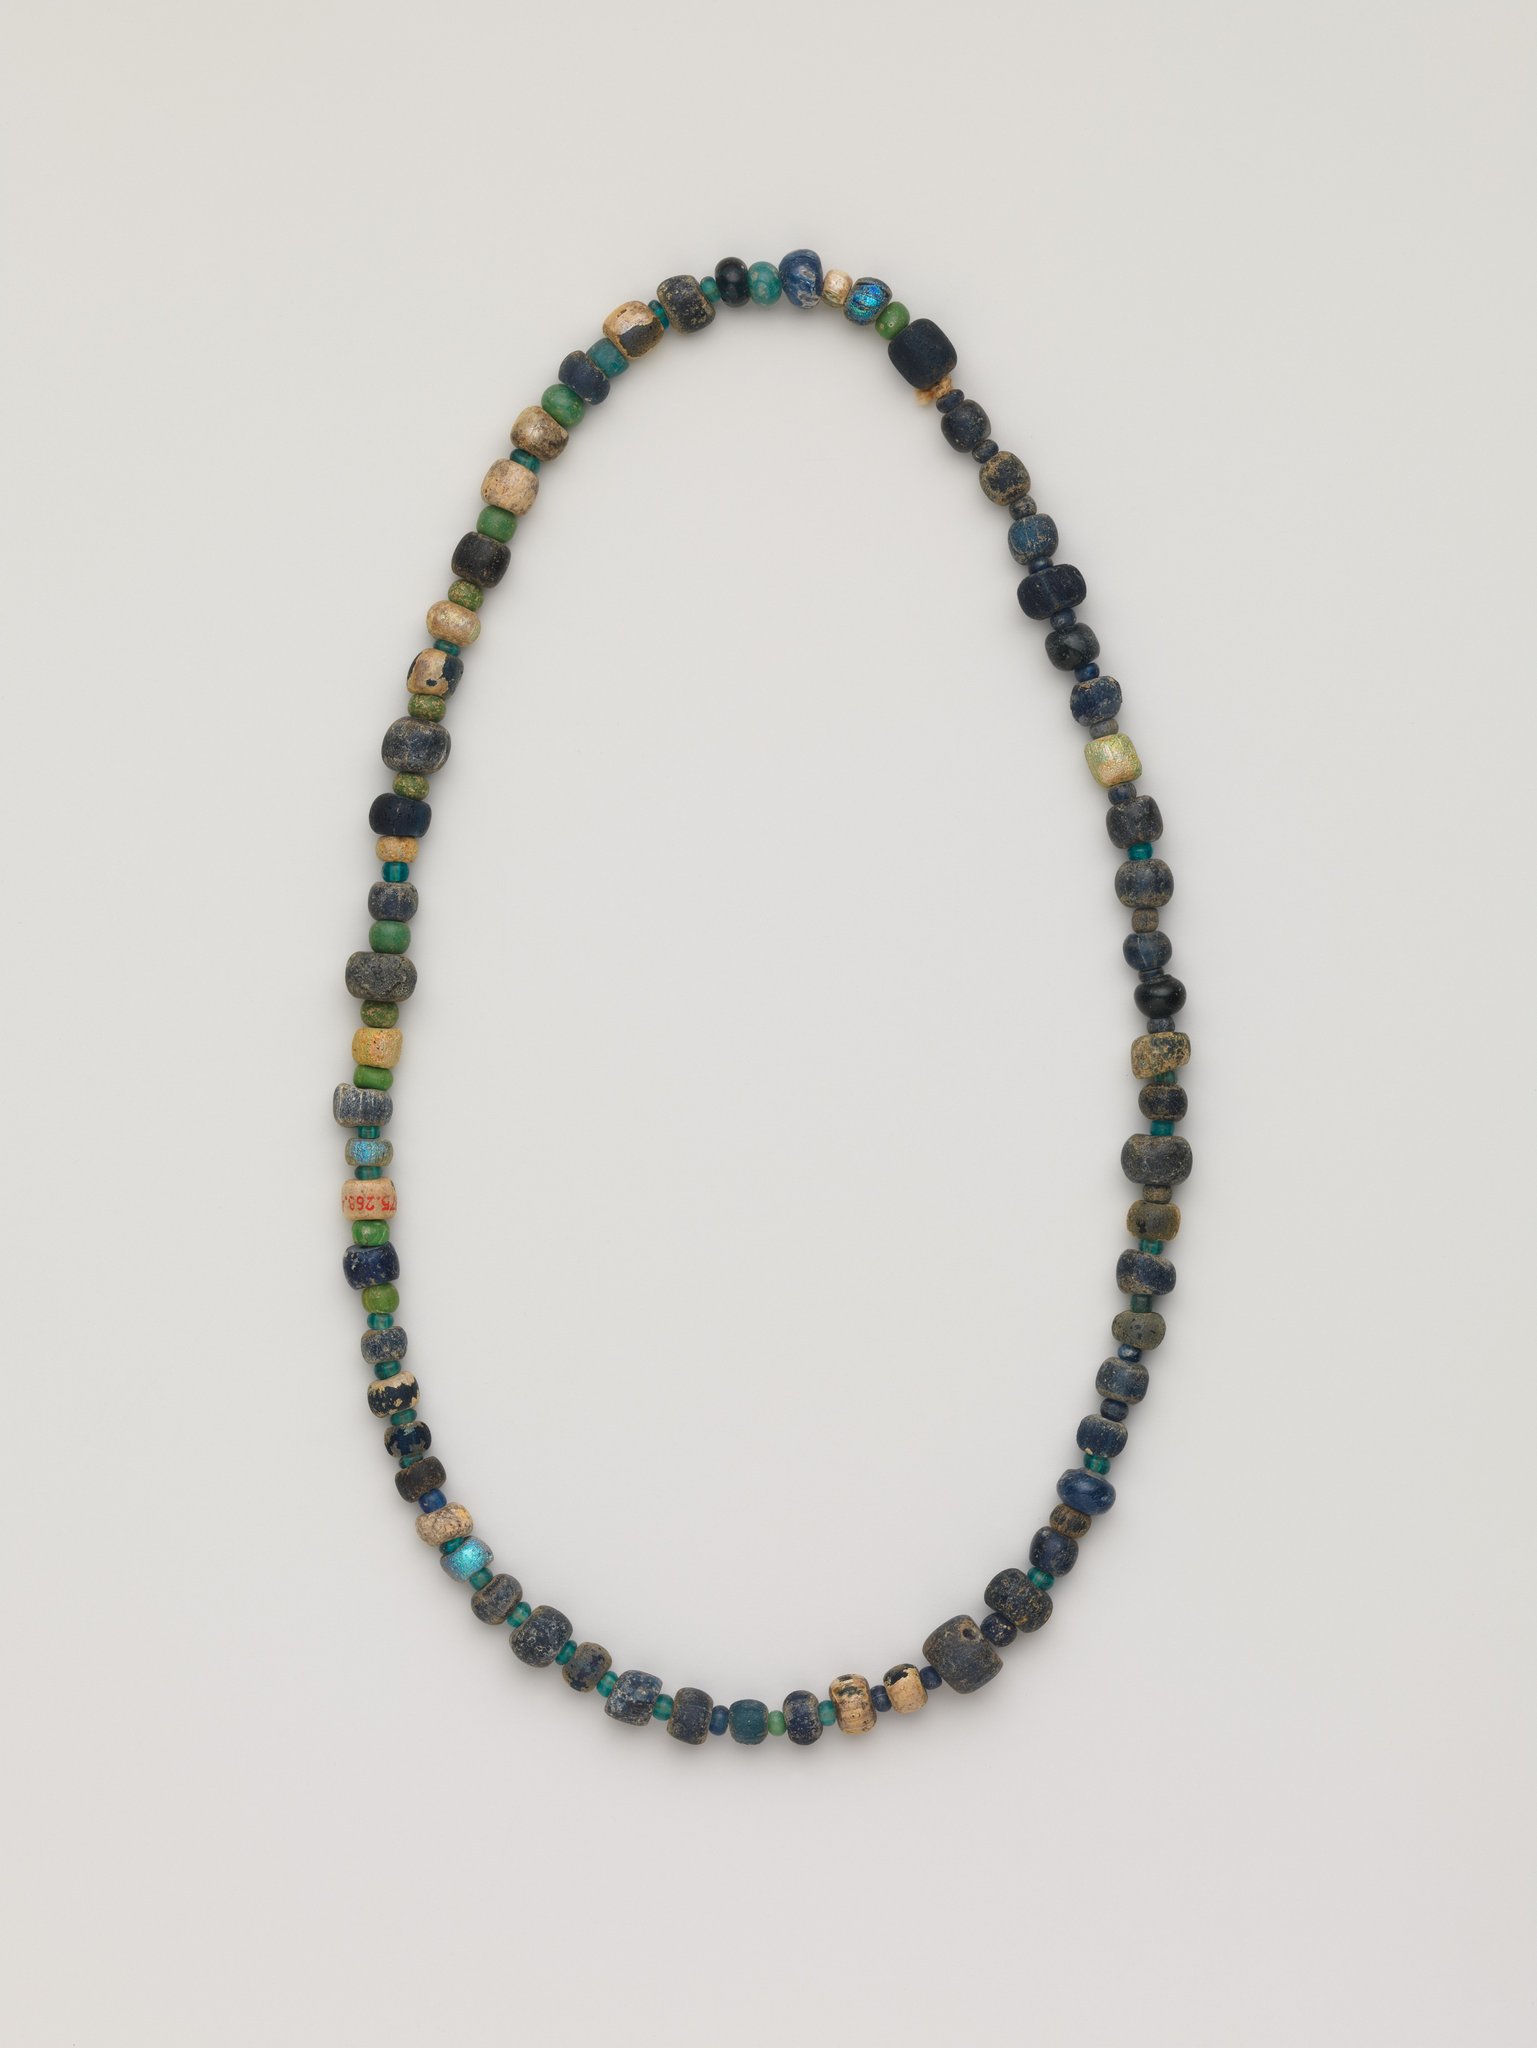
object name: necklace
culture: japanese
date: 501-600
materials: amber, glass, stone